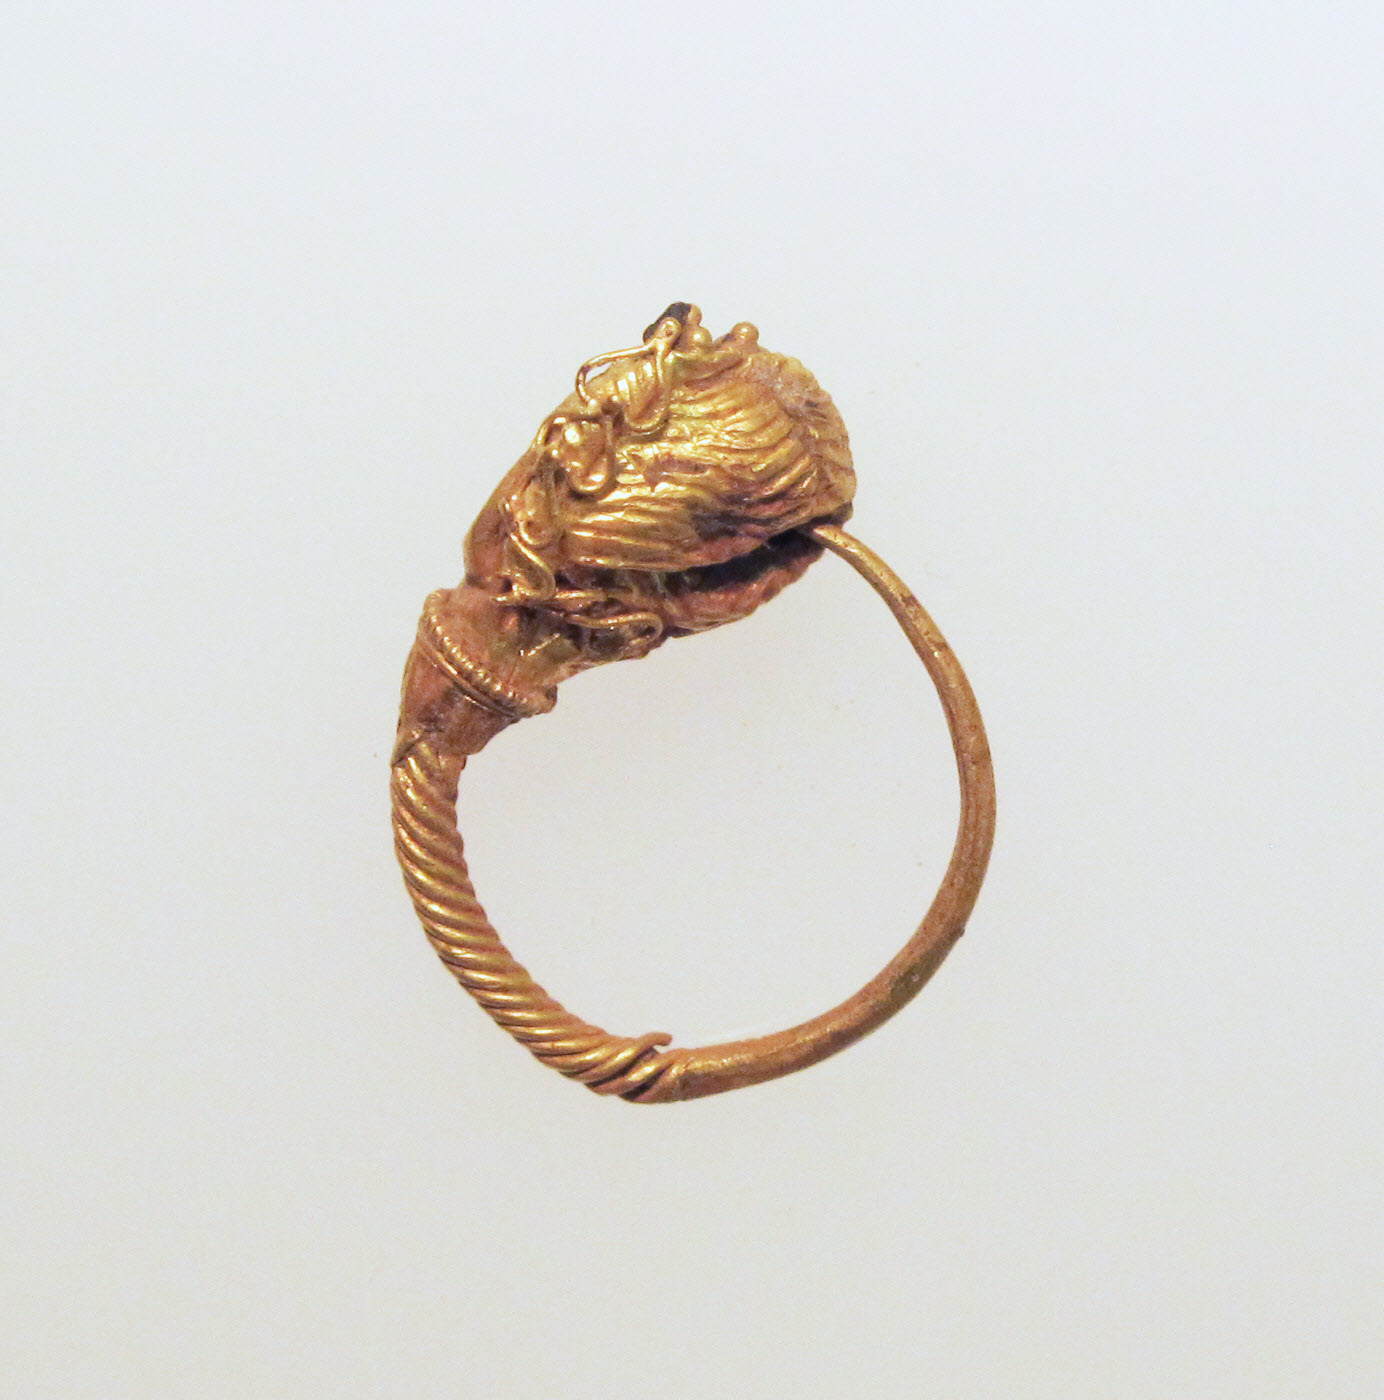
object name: earring with human head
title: Gold earring with woman's head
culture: greek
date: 300-101 BCE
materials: gold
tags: heads,women